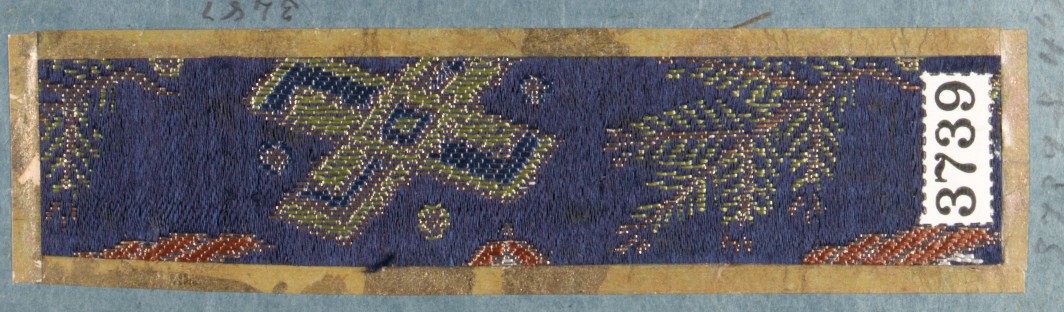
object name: sample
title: Textile Sample from Sample Book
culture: japanese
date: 1801-1900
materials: silk